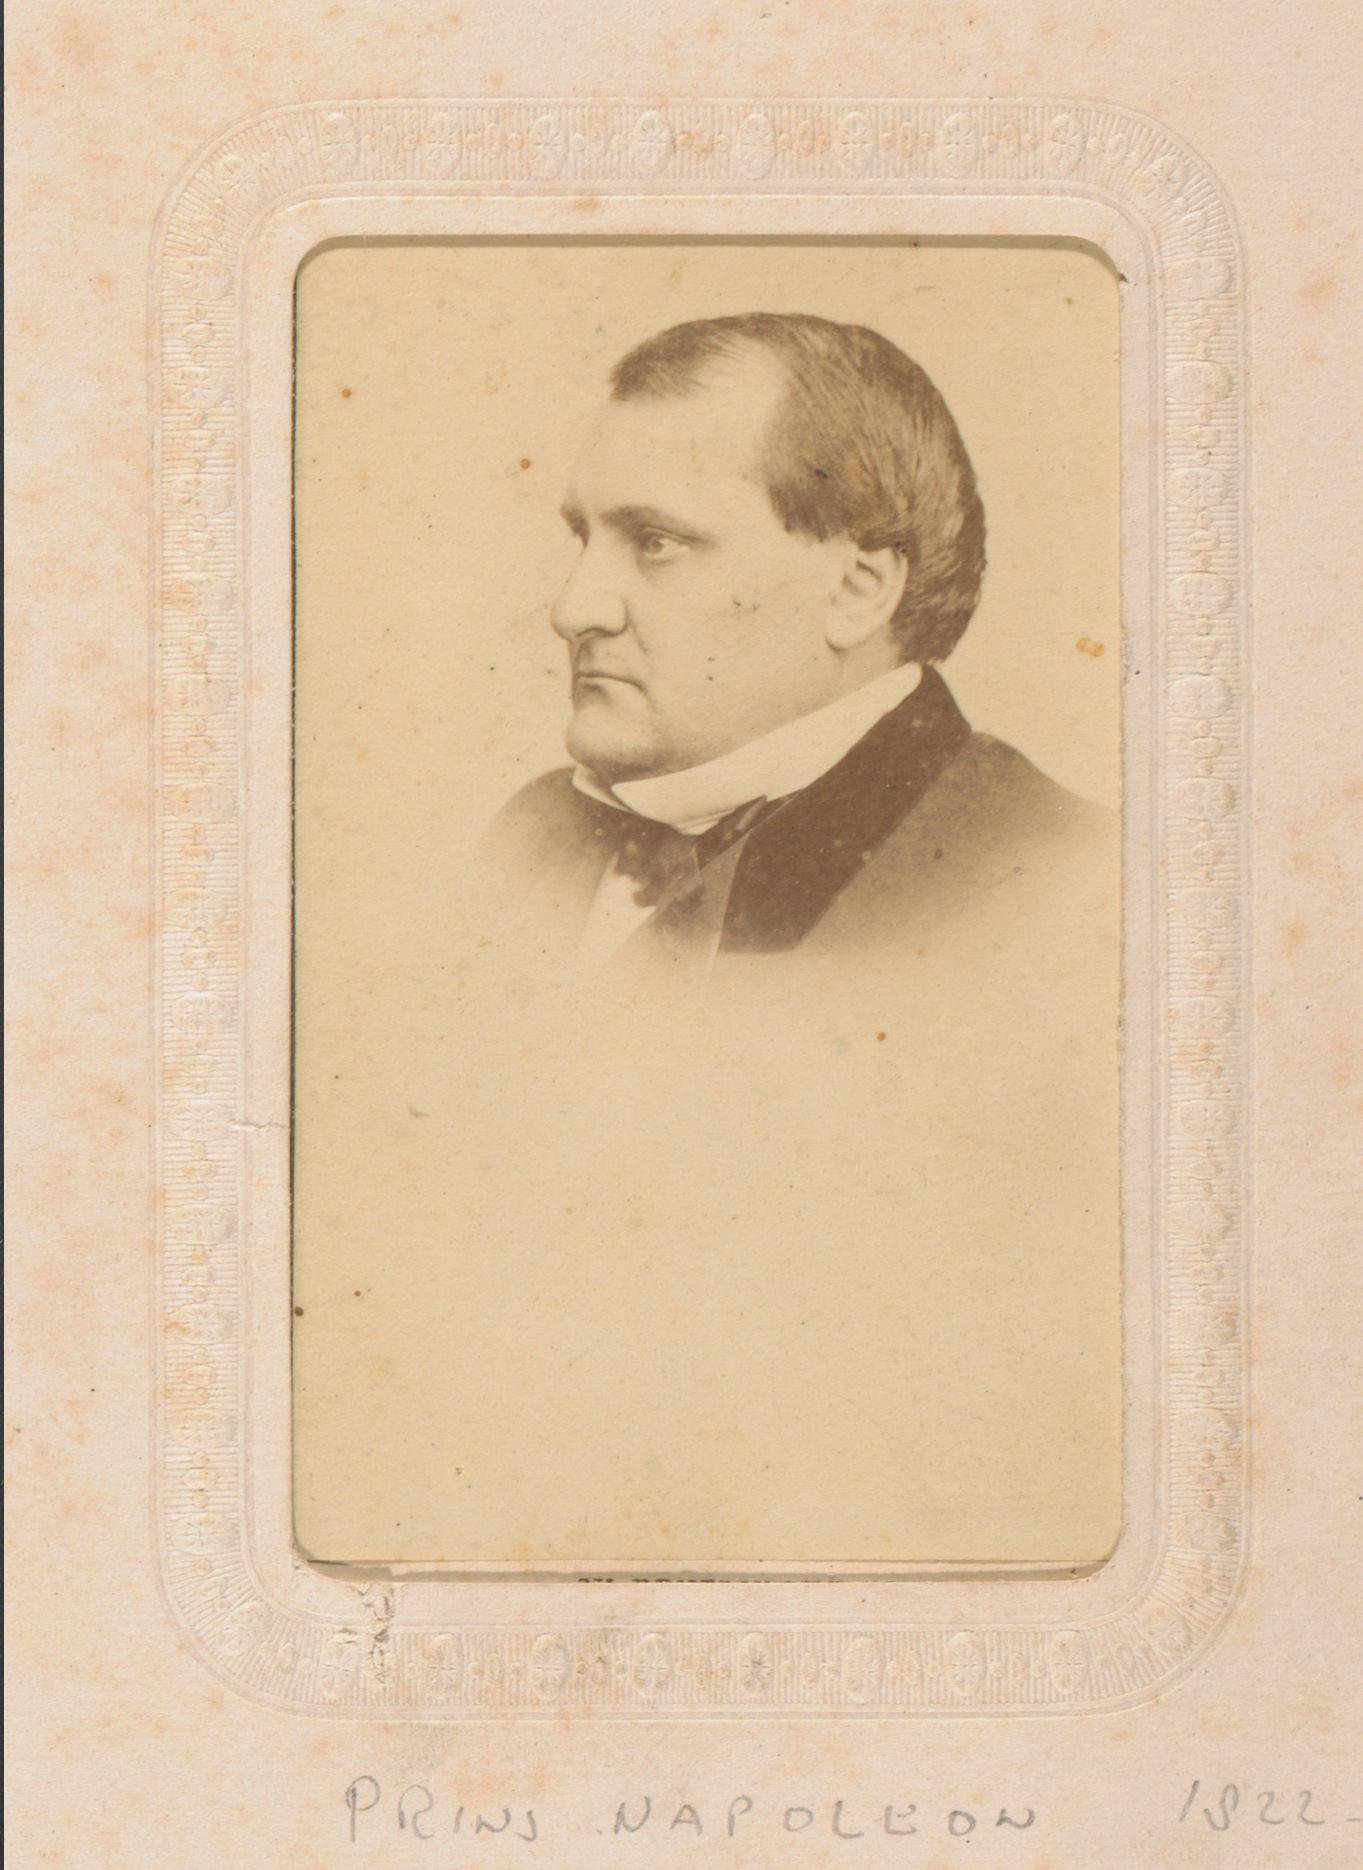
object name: album leaf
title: Portret van een Napoleon Jozef Karel Paul Bonaparte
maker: charles reutlinger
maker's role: publisher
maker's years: 1816-1880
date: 1855-1865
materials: cardboard, photographic support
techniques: albumen print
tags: politician, historical persons, politician, e.g. party leader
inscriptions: name: ‘Prins Napoleon 1822-1891’